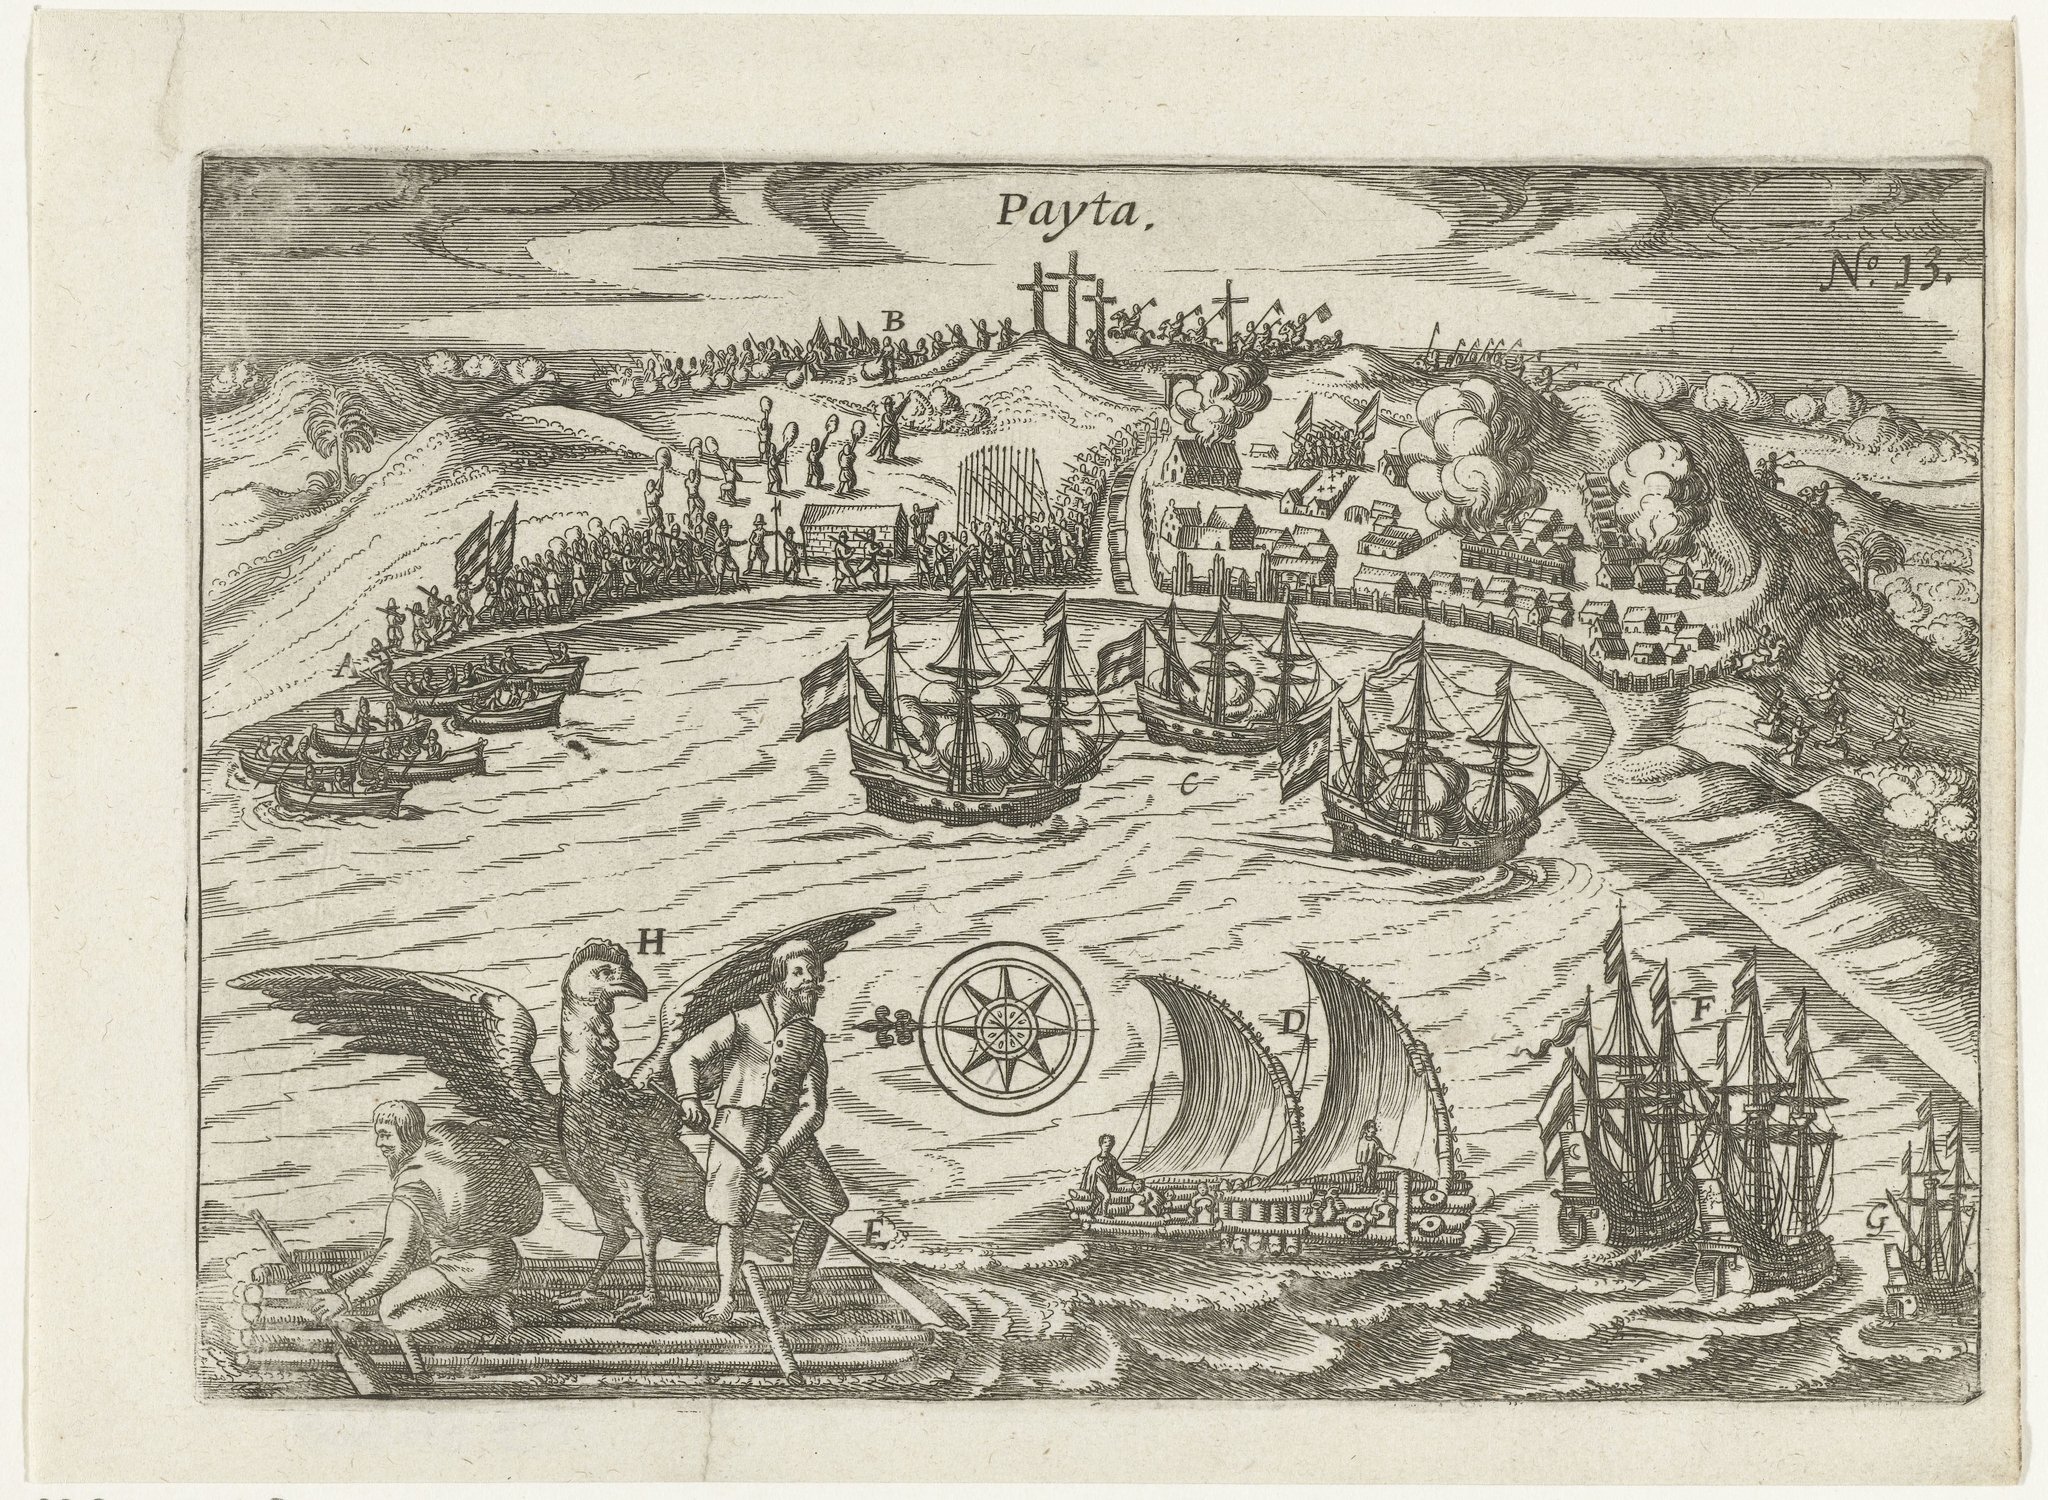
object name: print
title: Verovering van Paita, 1615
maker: Anonymous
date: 1617-1619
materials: paper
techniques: etching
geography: northern netherlands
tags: antwerp, bergen op zoom, landscapes in tropical and sub-tropical regions, exploration, expedition, voyage of discovery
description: Gebruikt als illustratie eerst in: J. van Spilbergen, Oost ende West-Indische spiegel der 2 leste navigatiën, ghedaen inden jaeren 1614, 15, 16, 17, ende 18. daer in vertoont woort, in wat gestalt Ioris van Speilbergen door de Magellanes de werelt rontom geseylt heeft ...; met de Australische navigatiën, van Iacob le Maire, ... met veel wonders ... in 26 coperen platen afghebeelt, N. Geelkerck, Leiden 1619. Later opnieuw gebruikt in : I. Commelin, Begin ende voortgangh, van de Vereenighde Nederlantsche Geoctroyeerde Oost-Indische Compagnie, J. Janssonius, Amsterdam 1646. Genummerd: No. 13.